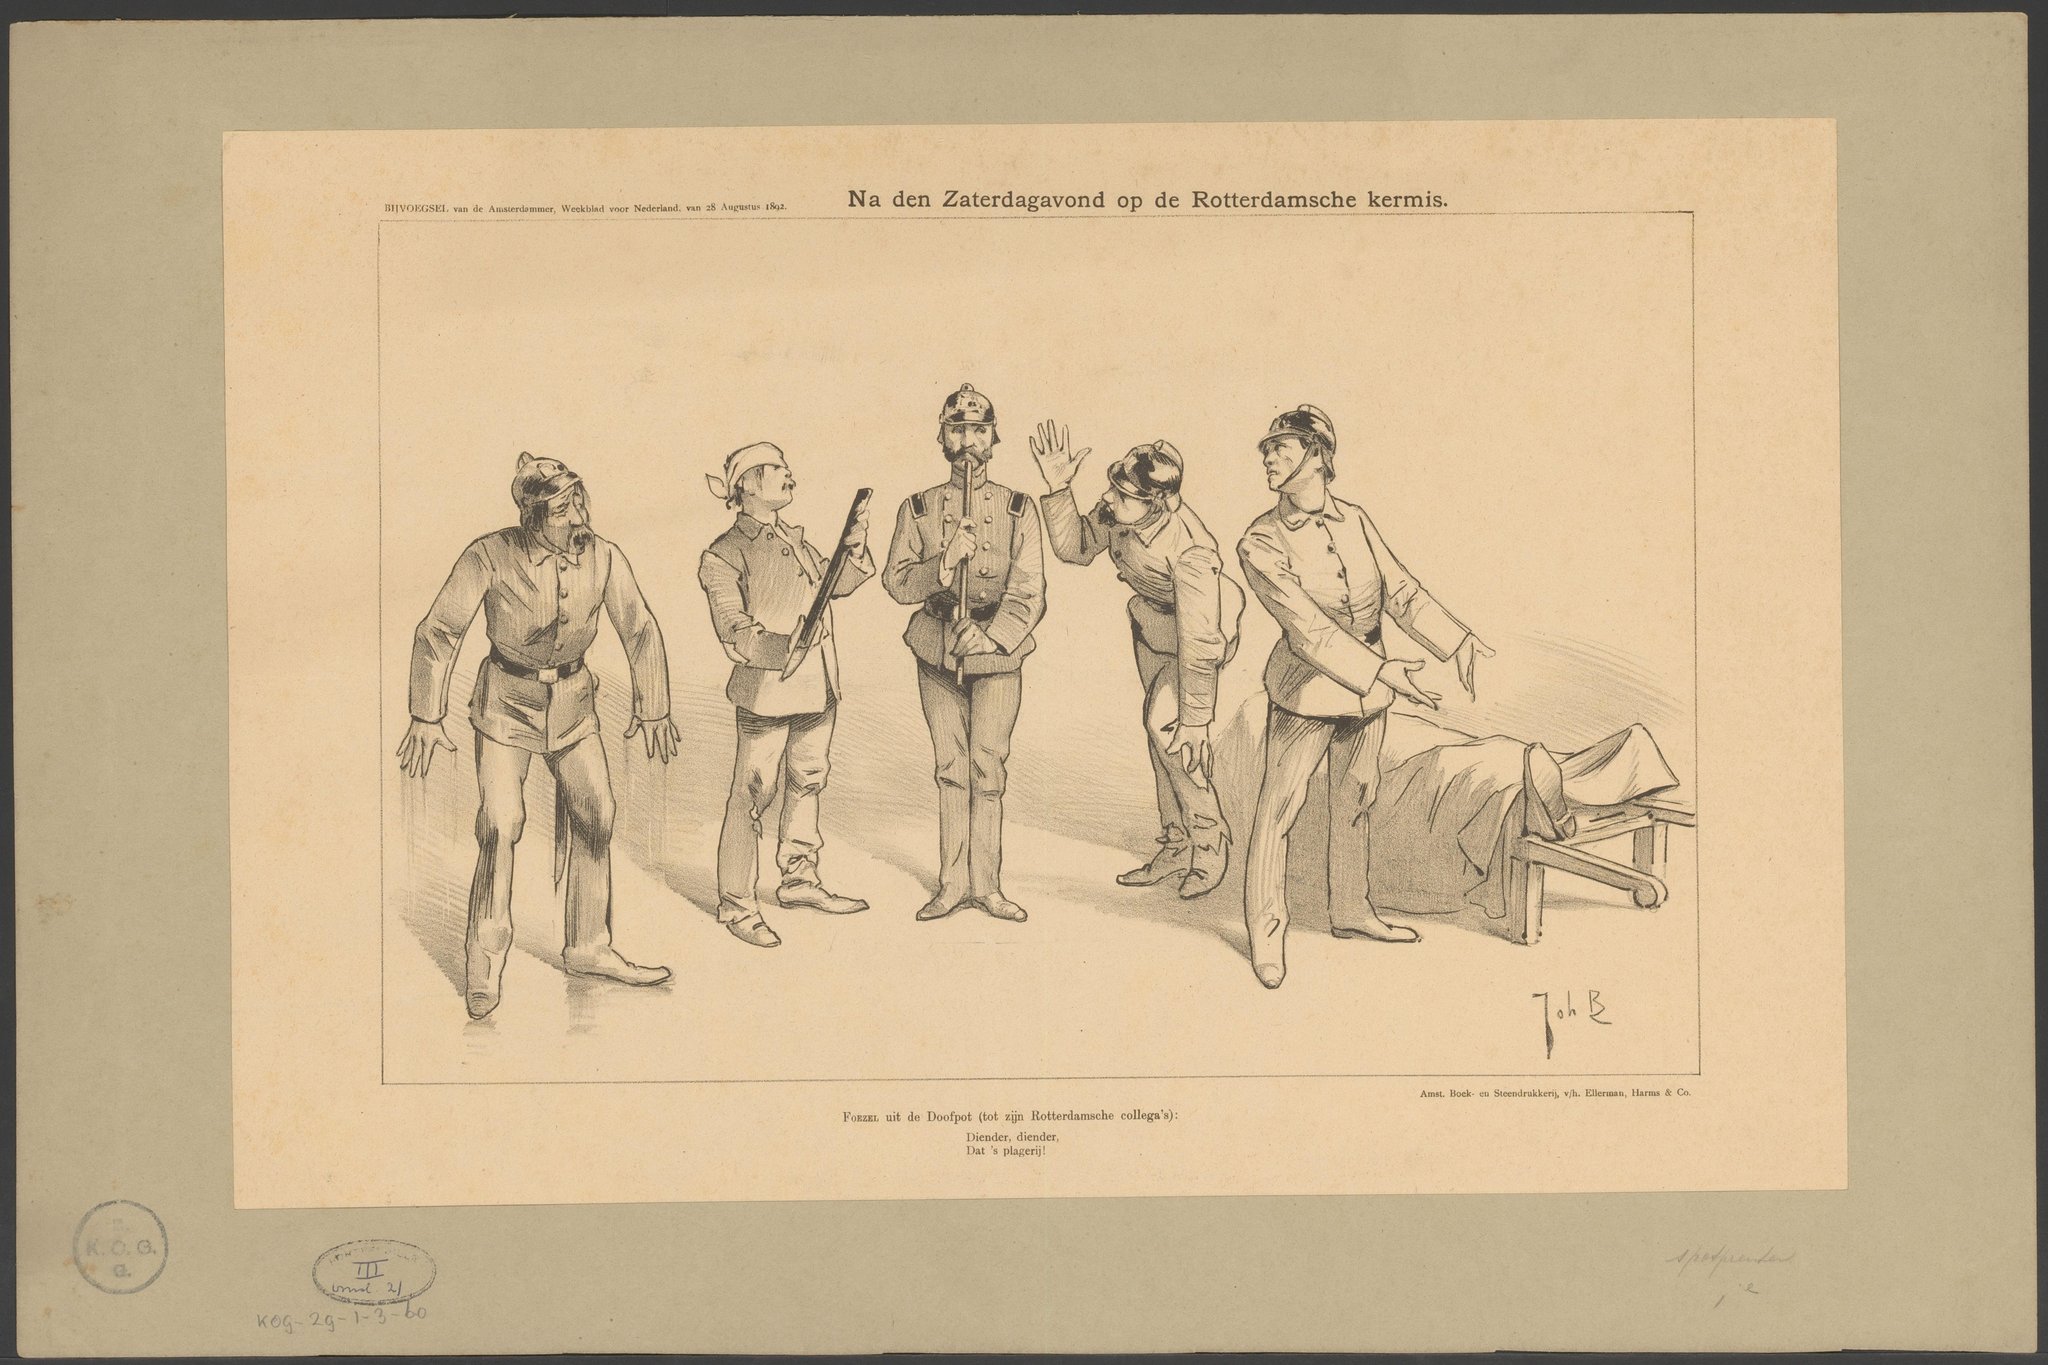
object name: print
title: Na den Zaterdagavond op de Rotterdamsche kermis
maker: johan braakensiek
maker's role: draughtsman, print maker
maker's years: 1858-1940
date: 1892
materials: paper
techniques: letterpress printing, lithograph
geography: amsterdam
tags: flute, aulos, tibia, police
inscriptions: collector's mark: Lugt 1641, stamp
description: Spotprent op de ongeregeldheden op de zaterdagavond van de Rotterdamse kermis. Onderaan de tekst: Foezel uit de Doofpot (tot zijn Rotterdamsche collega's): Diender, diender, Dat's plagerij!". Onderwerpsrubrieken binnen de Atlas Zeden en Gewoonten: Regeering, Spotprenten.